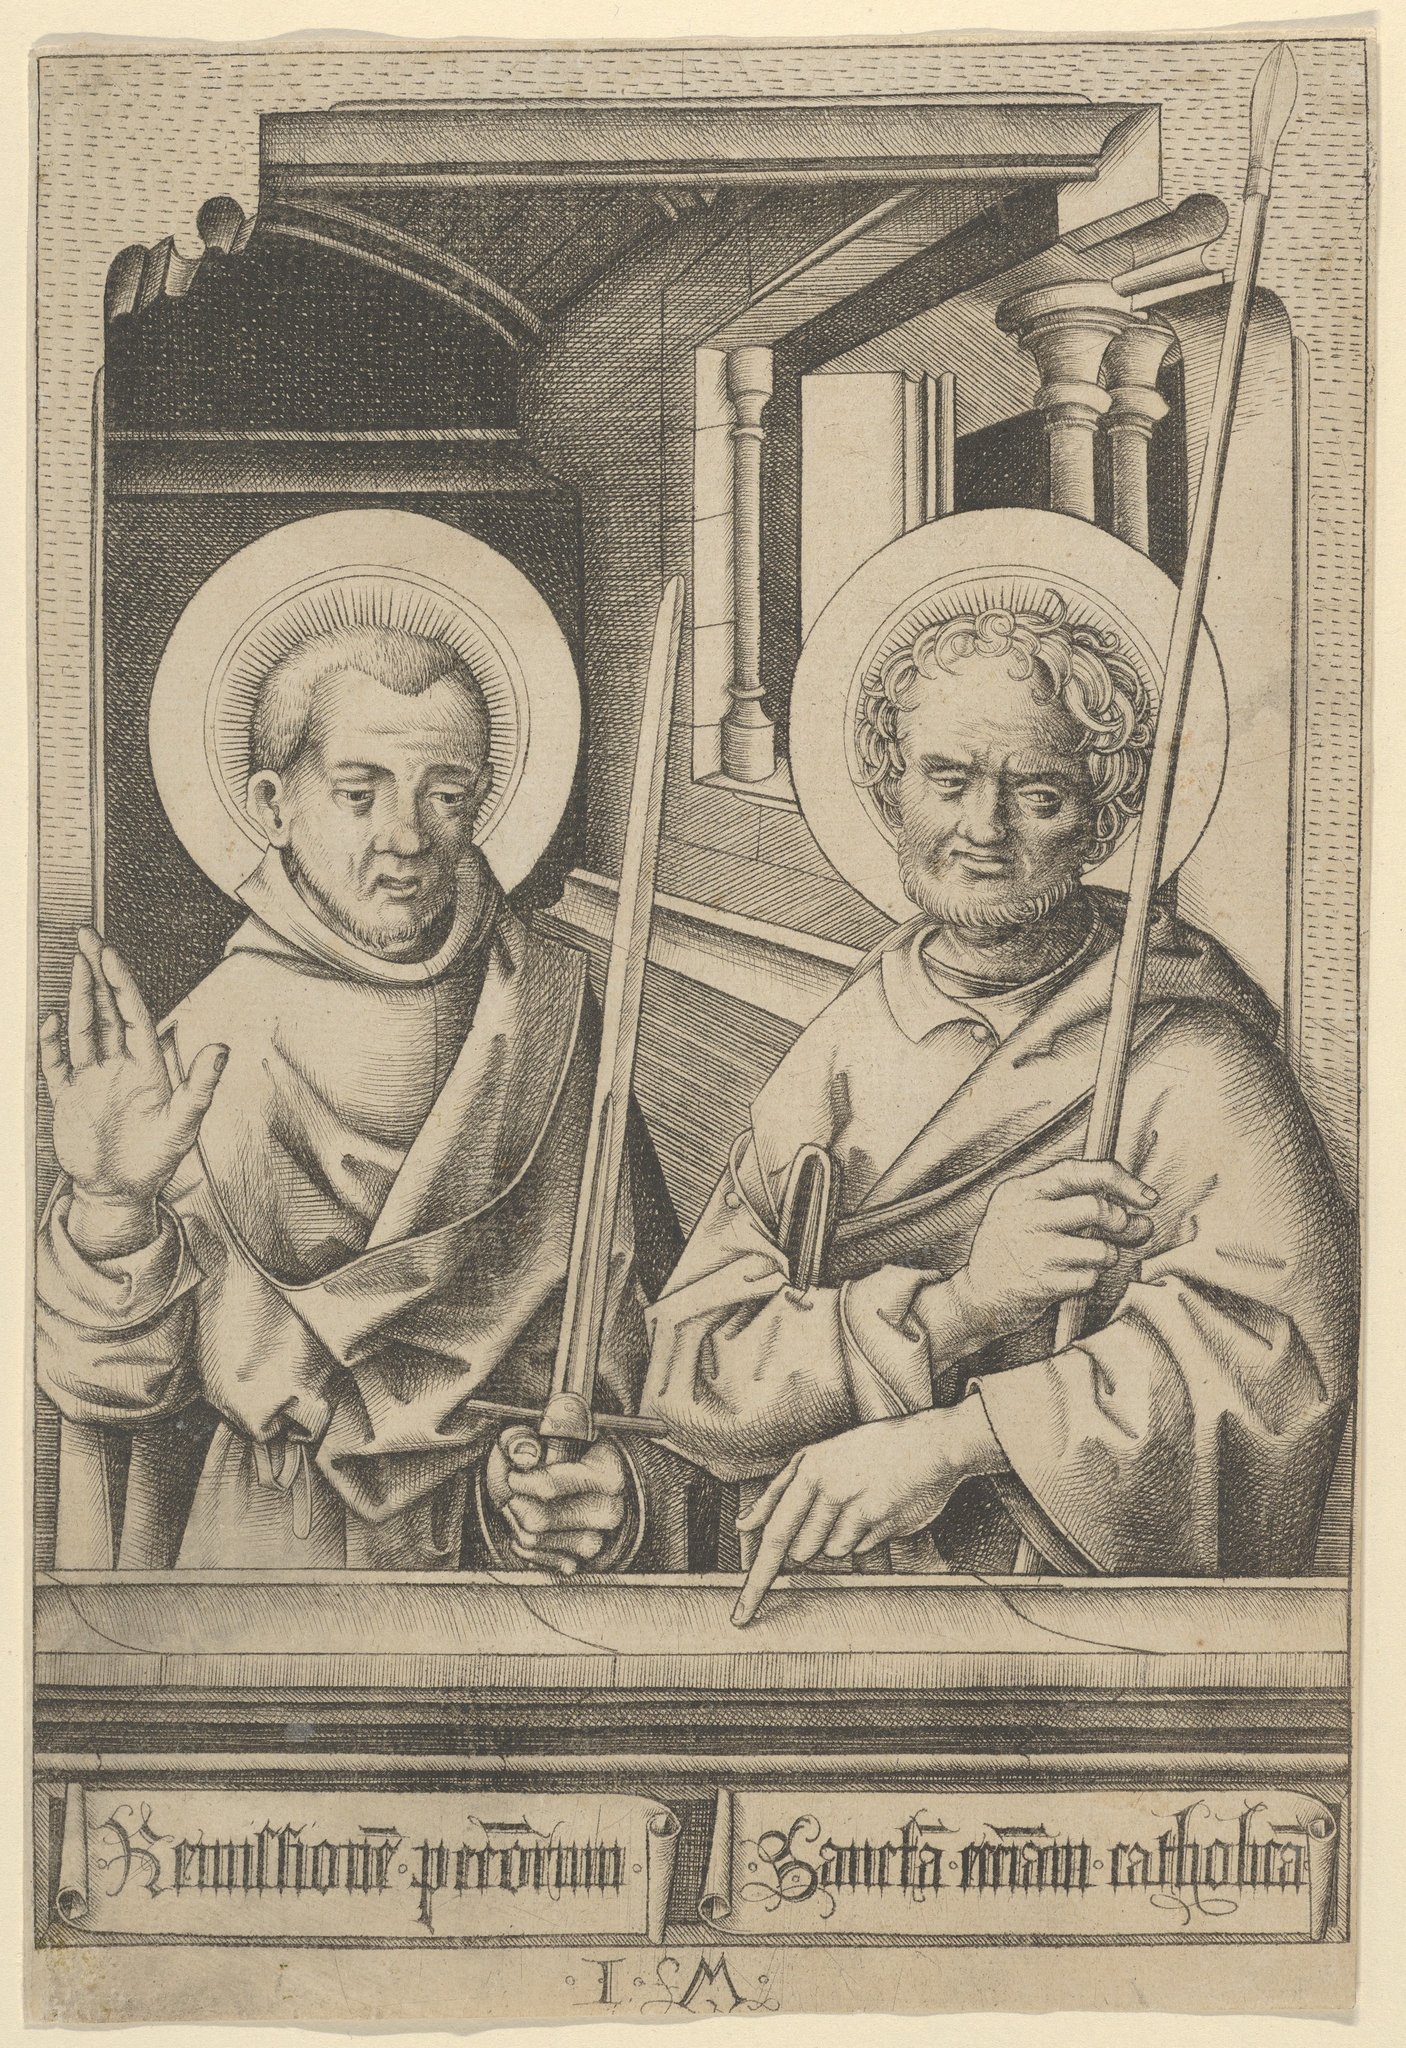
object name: print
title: St. Simon (?) and St. Matthew, from The Apostles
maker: israhel van meckenem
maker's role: artist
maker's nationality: german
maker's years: 1435-1503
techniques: engraving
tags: weapons,apostles,saint matthew,saints